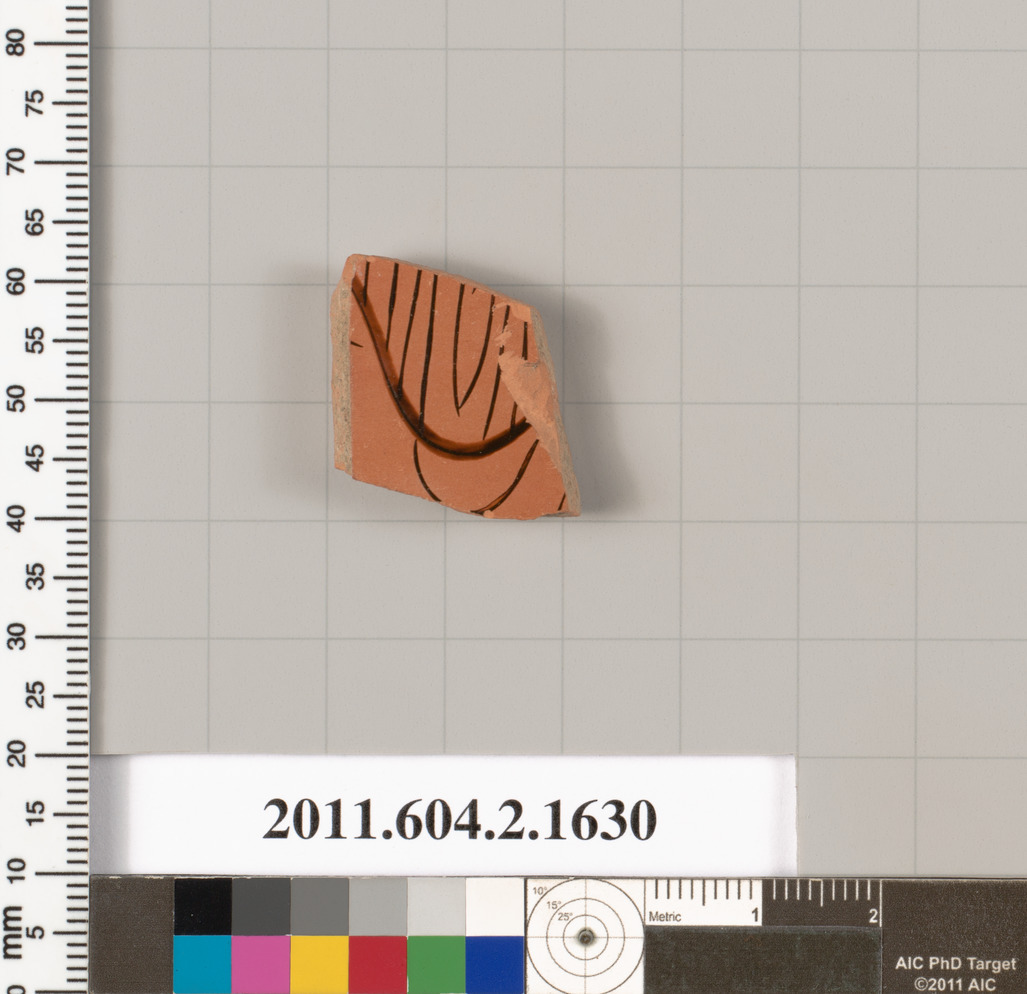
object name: skyphos fragment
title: Terracotta fragment of a skyphos (deep drinking cup)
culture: greek, attic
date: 460-440 BCE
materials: terracotta